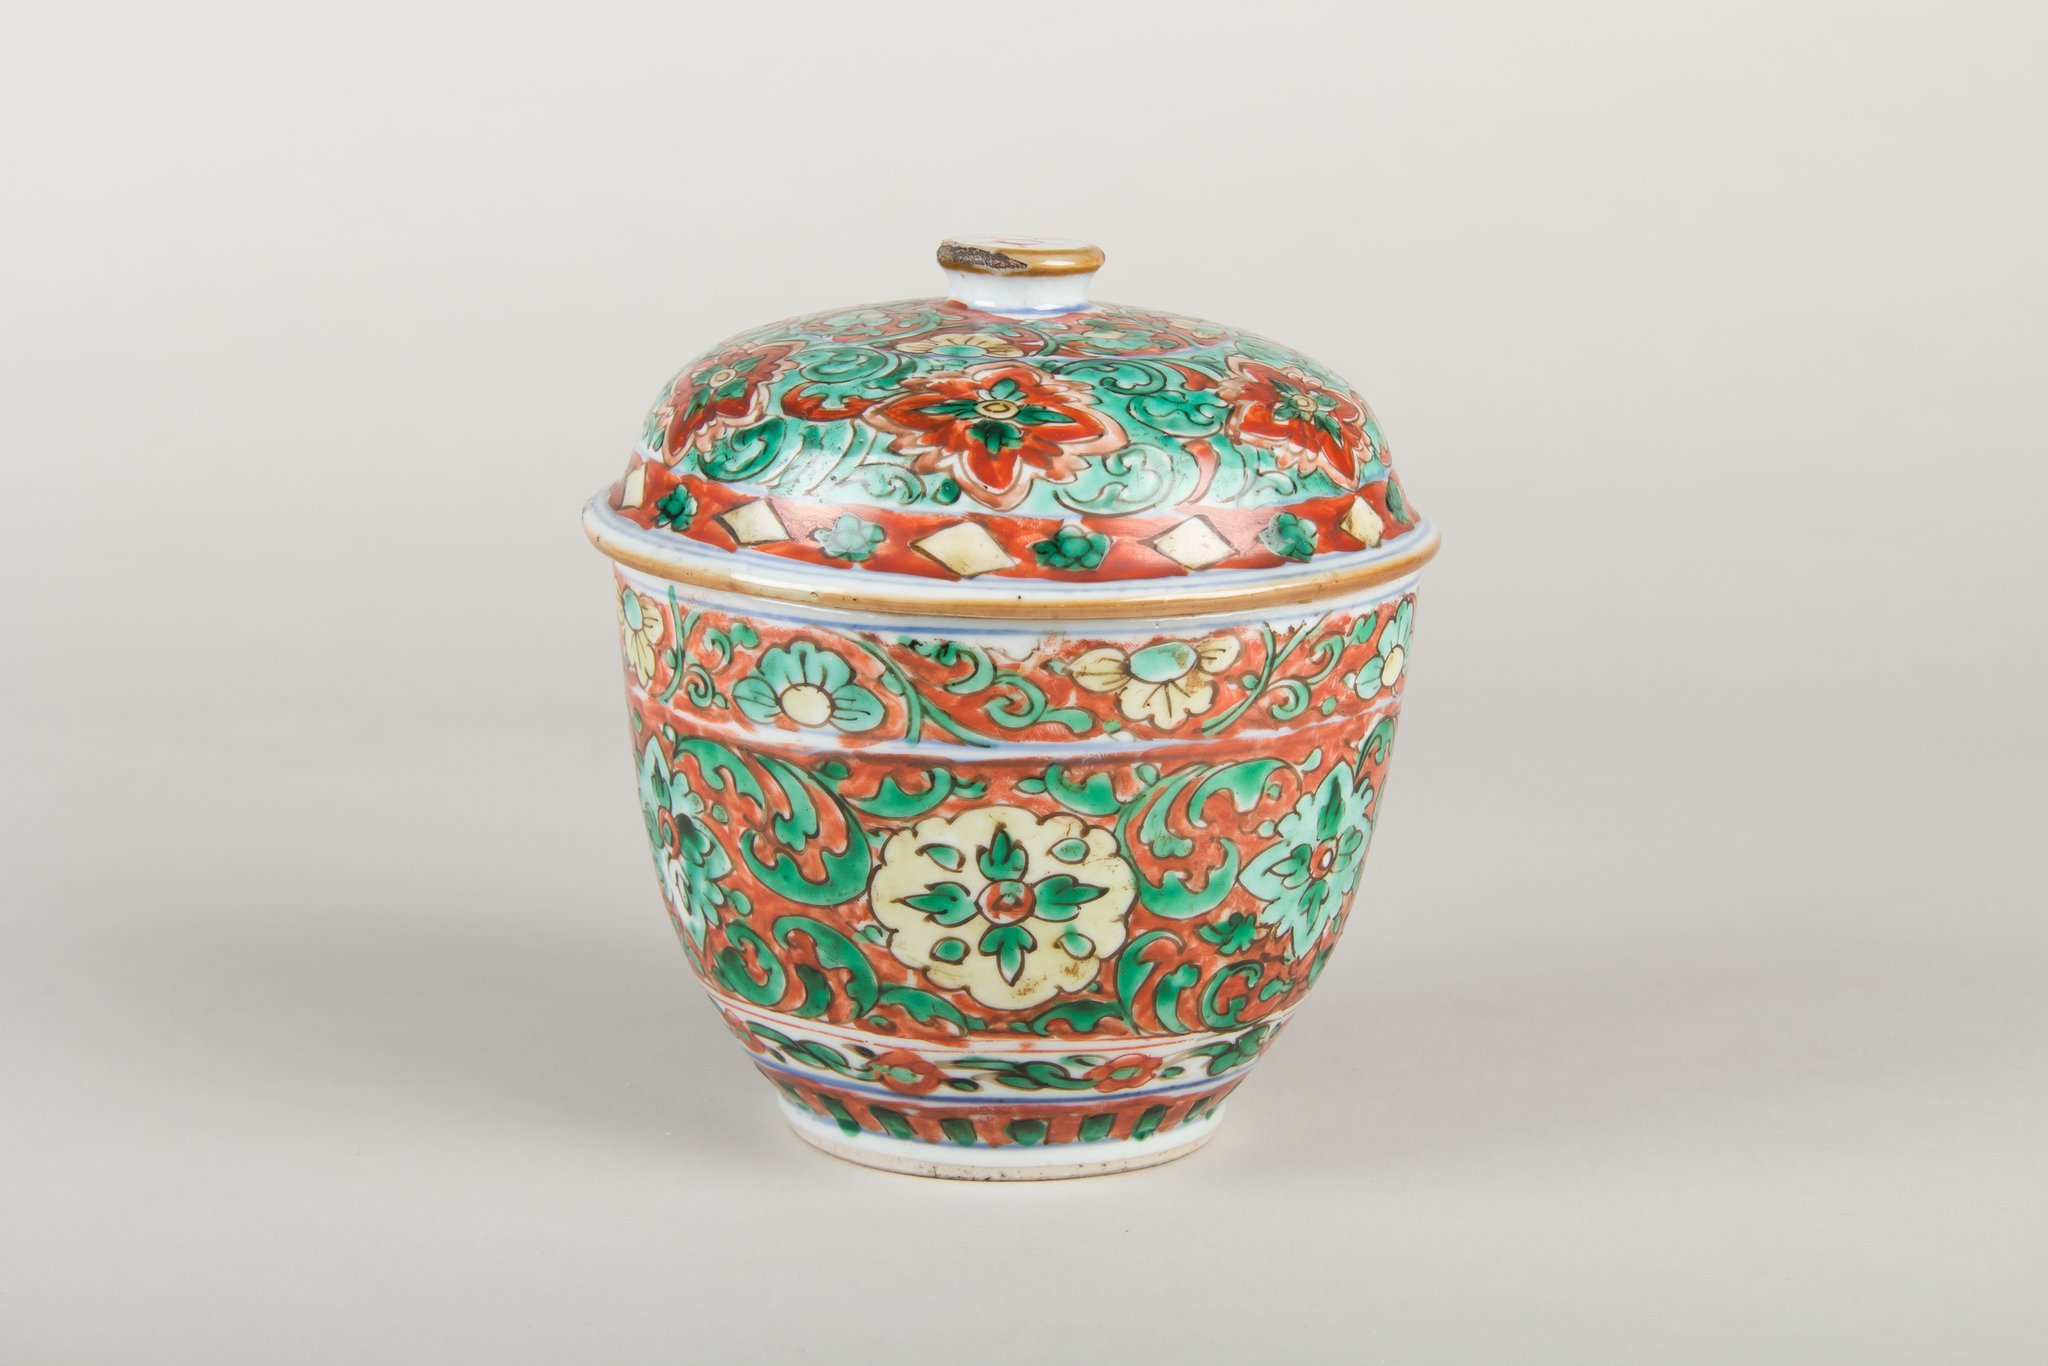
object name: covered jar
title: Covered jar with floral patterns (one of a pair)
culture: chinese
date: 1667-1700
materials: enamel, porcelain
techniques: overglaze, painting, polychrome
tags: flowers